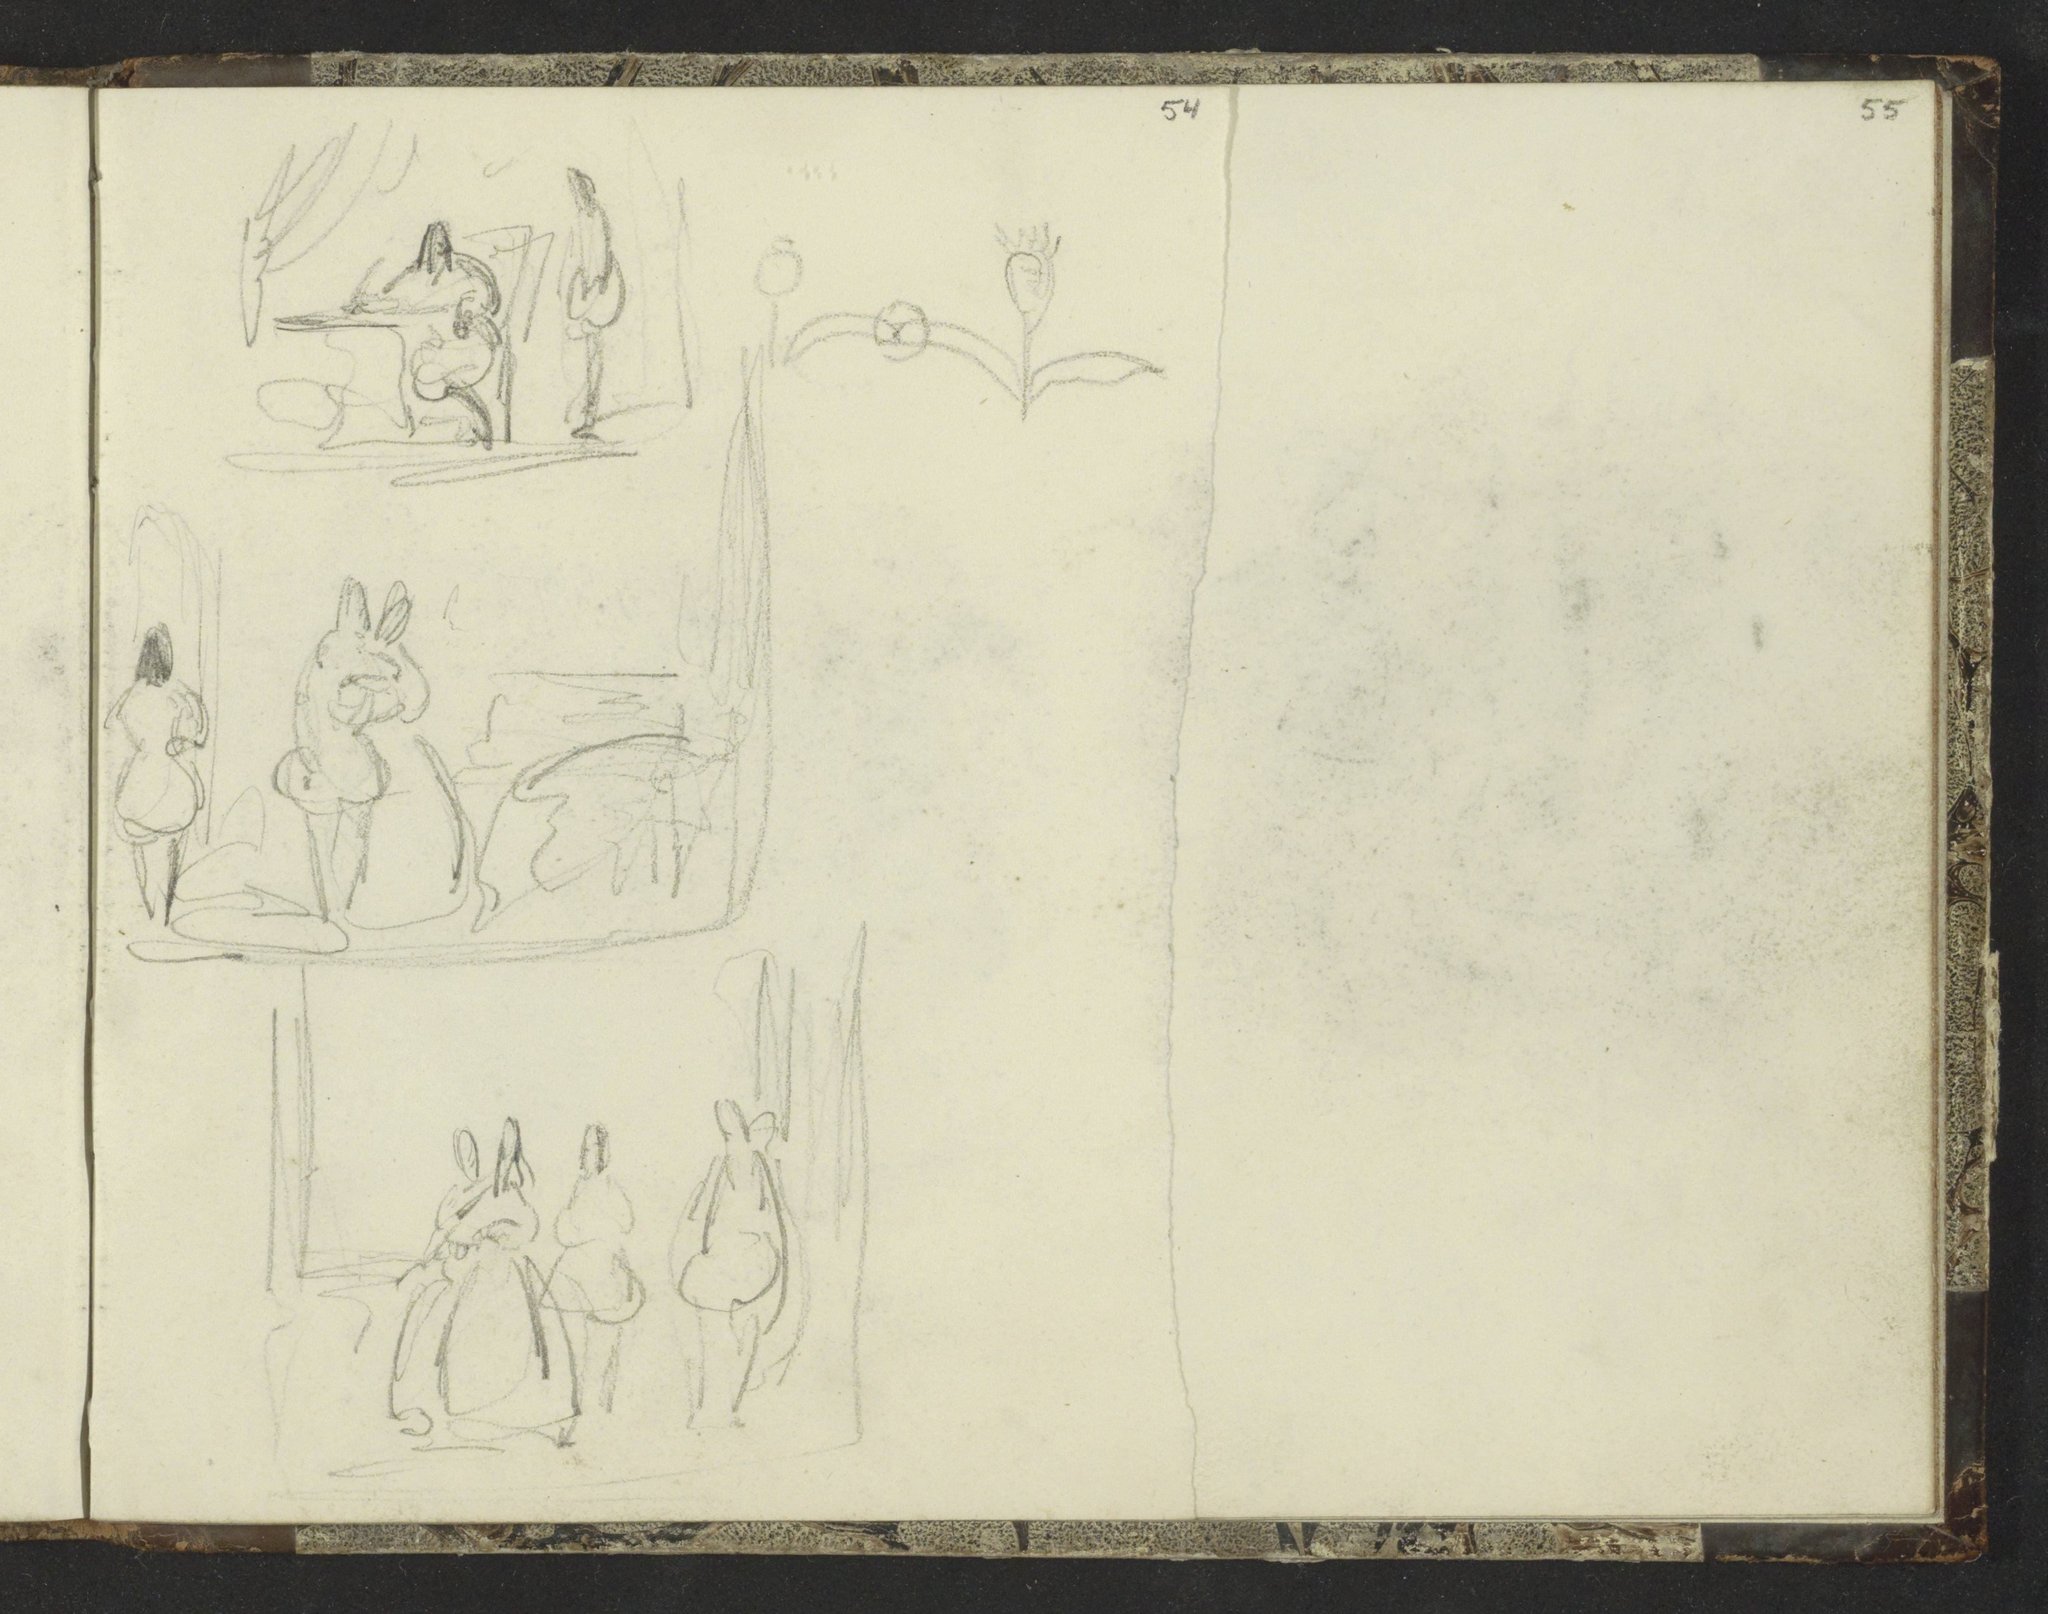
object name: sketchbook leaf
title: Compositiestudies met interieurs en een ornament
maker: willem hendrik schmidt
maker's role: draughtsman, painter, print maker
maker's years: 1809-1849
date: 1819-1849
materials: paper, pencil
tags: ornaments ~ art, anatomy (non-medical), interior of the house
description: Het blad is deels uit het schetsboek gescheurd.